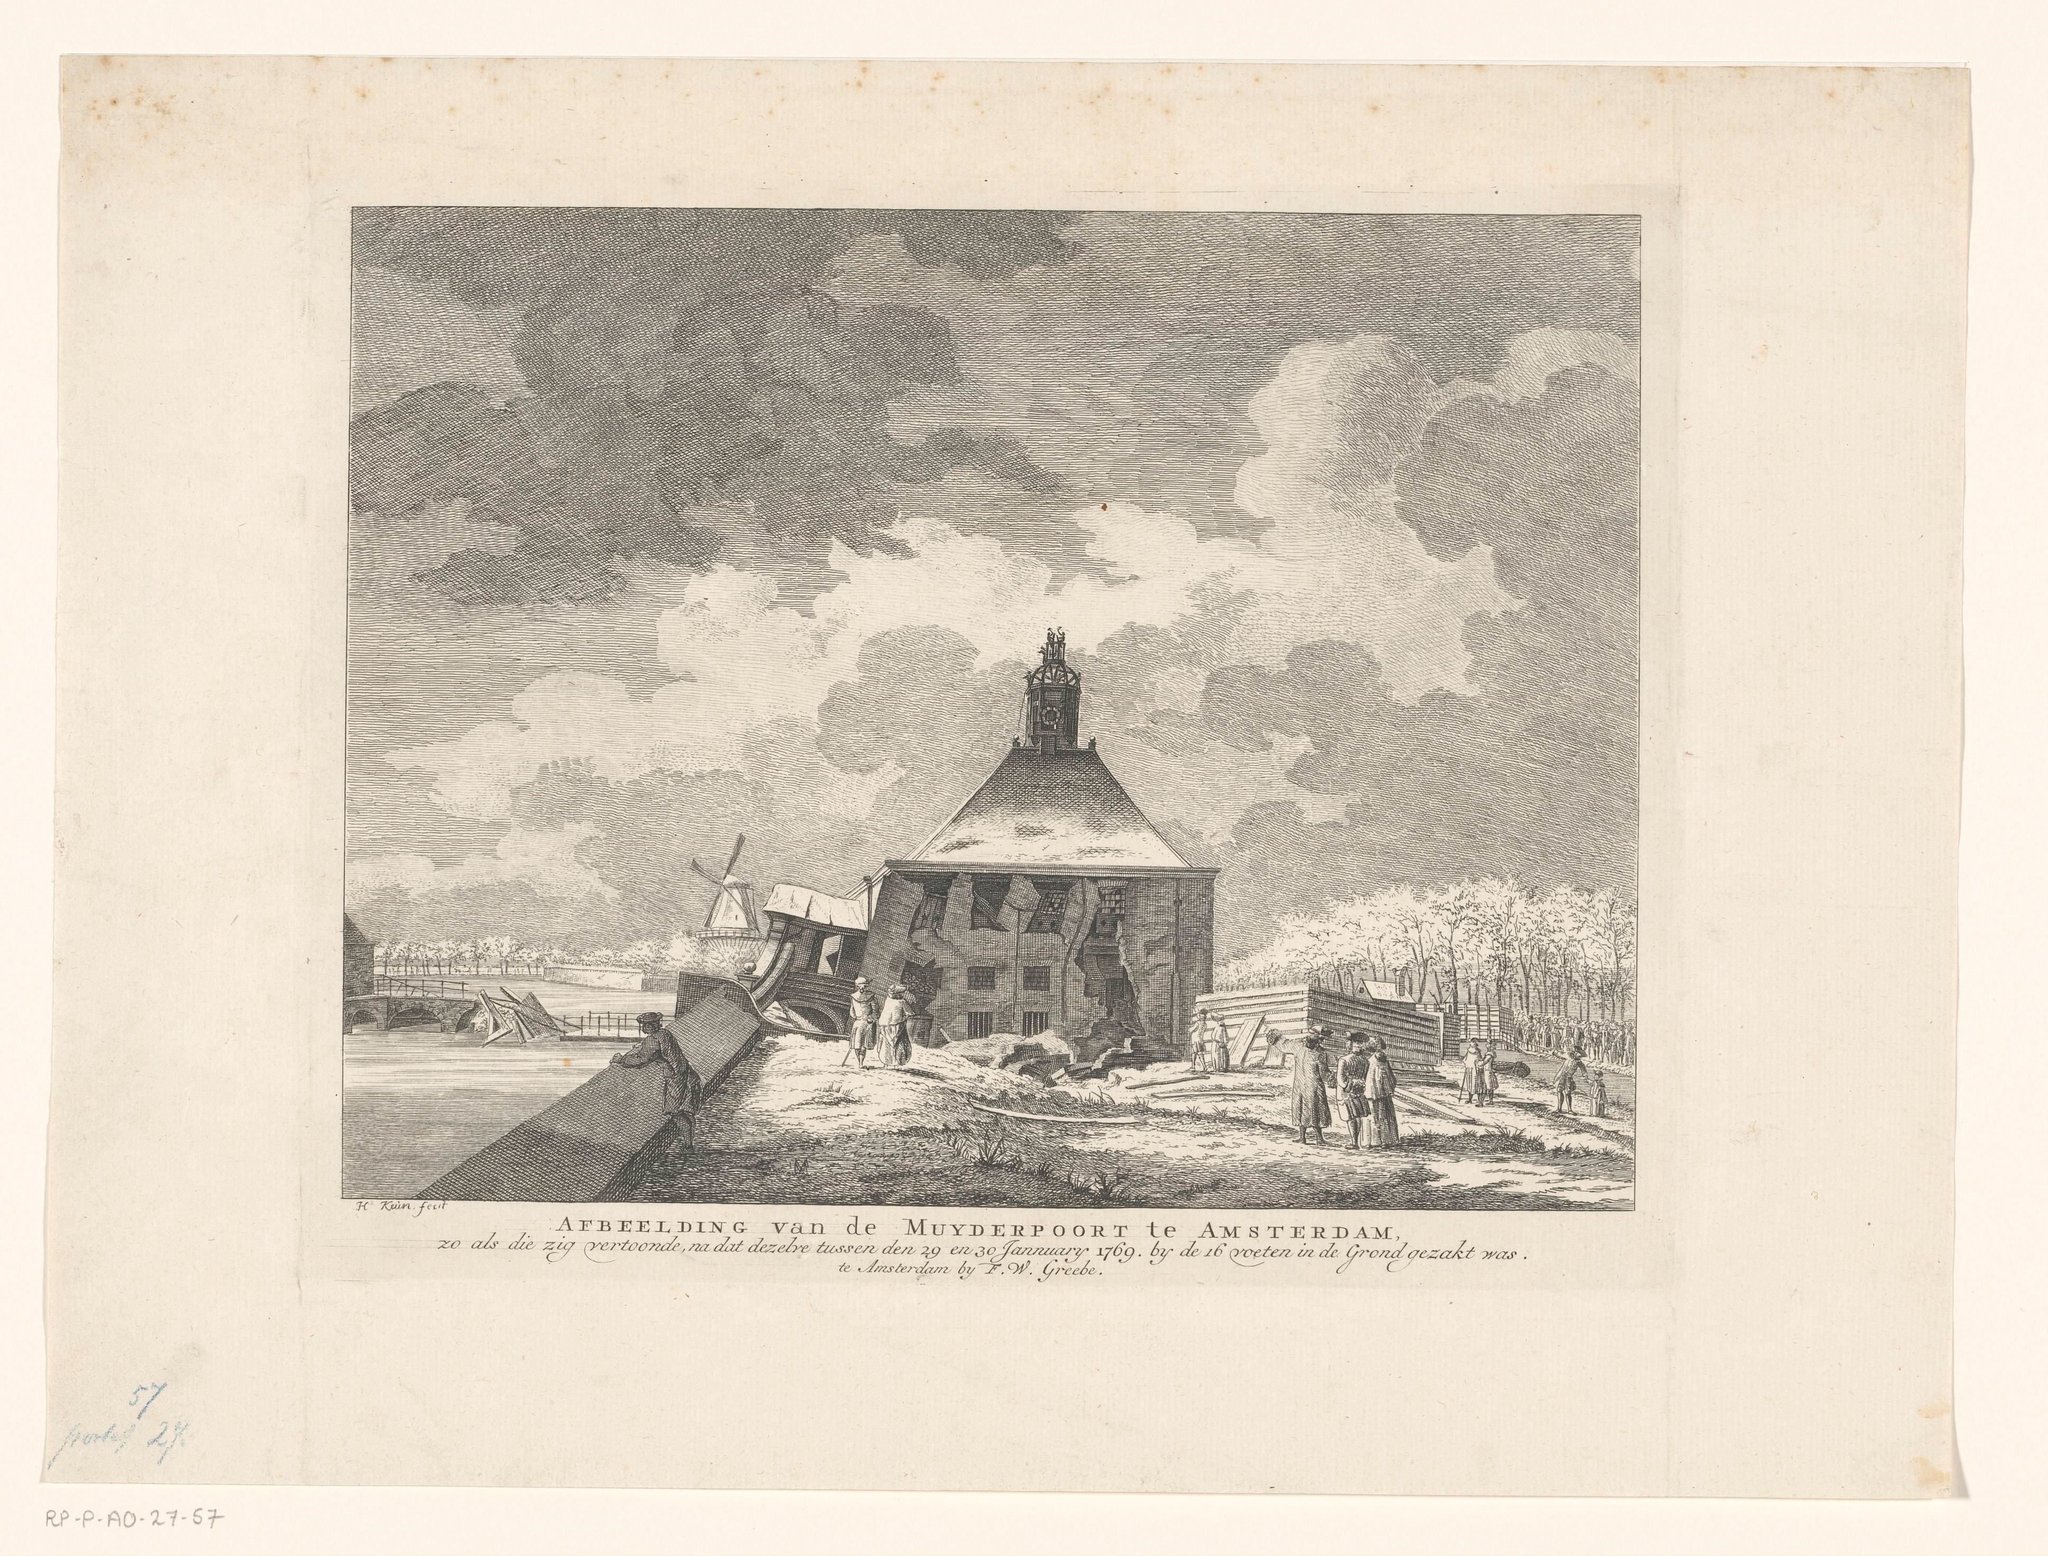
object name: print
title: Verzakte Muiderpoort, gezien vanaf de schans, 1769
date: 1769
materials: paper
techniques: engraving, etching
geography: northern netherlands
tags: city-gate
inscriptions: collector's mark: Lugt 2228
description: De verzakte Muiderpoort te Amsterdam, gezien vanaf de schans, 30 januari 1769. Met links de Singelgracht, rechts de Muidergracht. Op de voorgrond enkele toeschouwers.